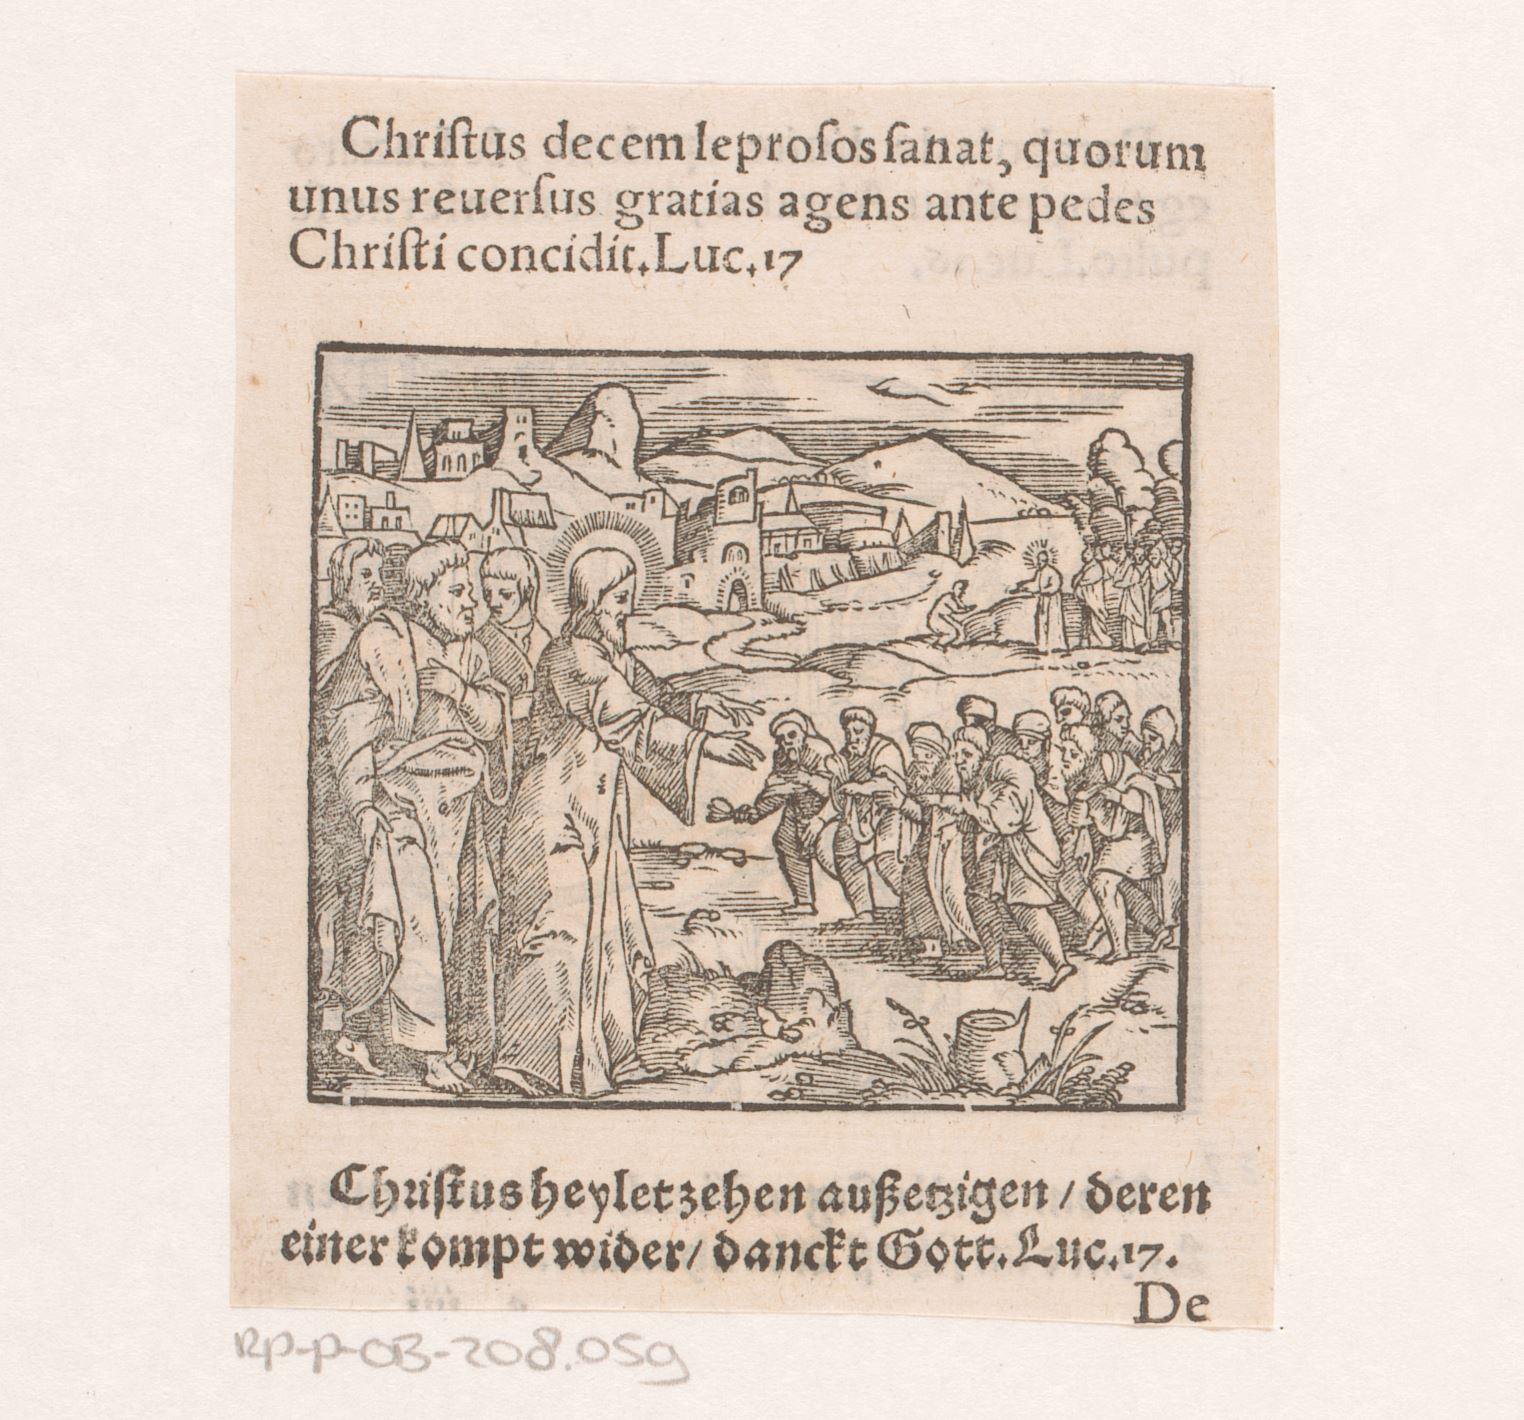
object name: print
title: Christus geneest tien melaatsen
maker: Anonymous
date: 1600-1699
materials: paper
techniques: letterpress printing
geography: netherlands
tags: christ sends ten lepers to the priest (luke 17:11-19)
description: Christus ontmoet tien mensen die aan huidvraat lijden en geeft hen de opdracht om zich aan de priesters te laten zien. Als ze dat doen blijkt dat ze zijn genezen.